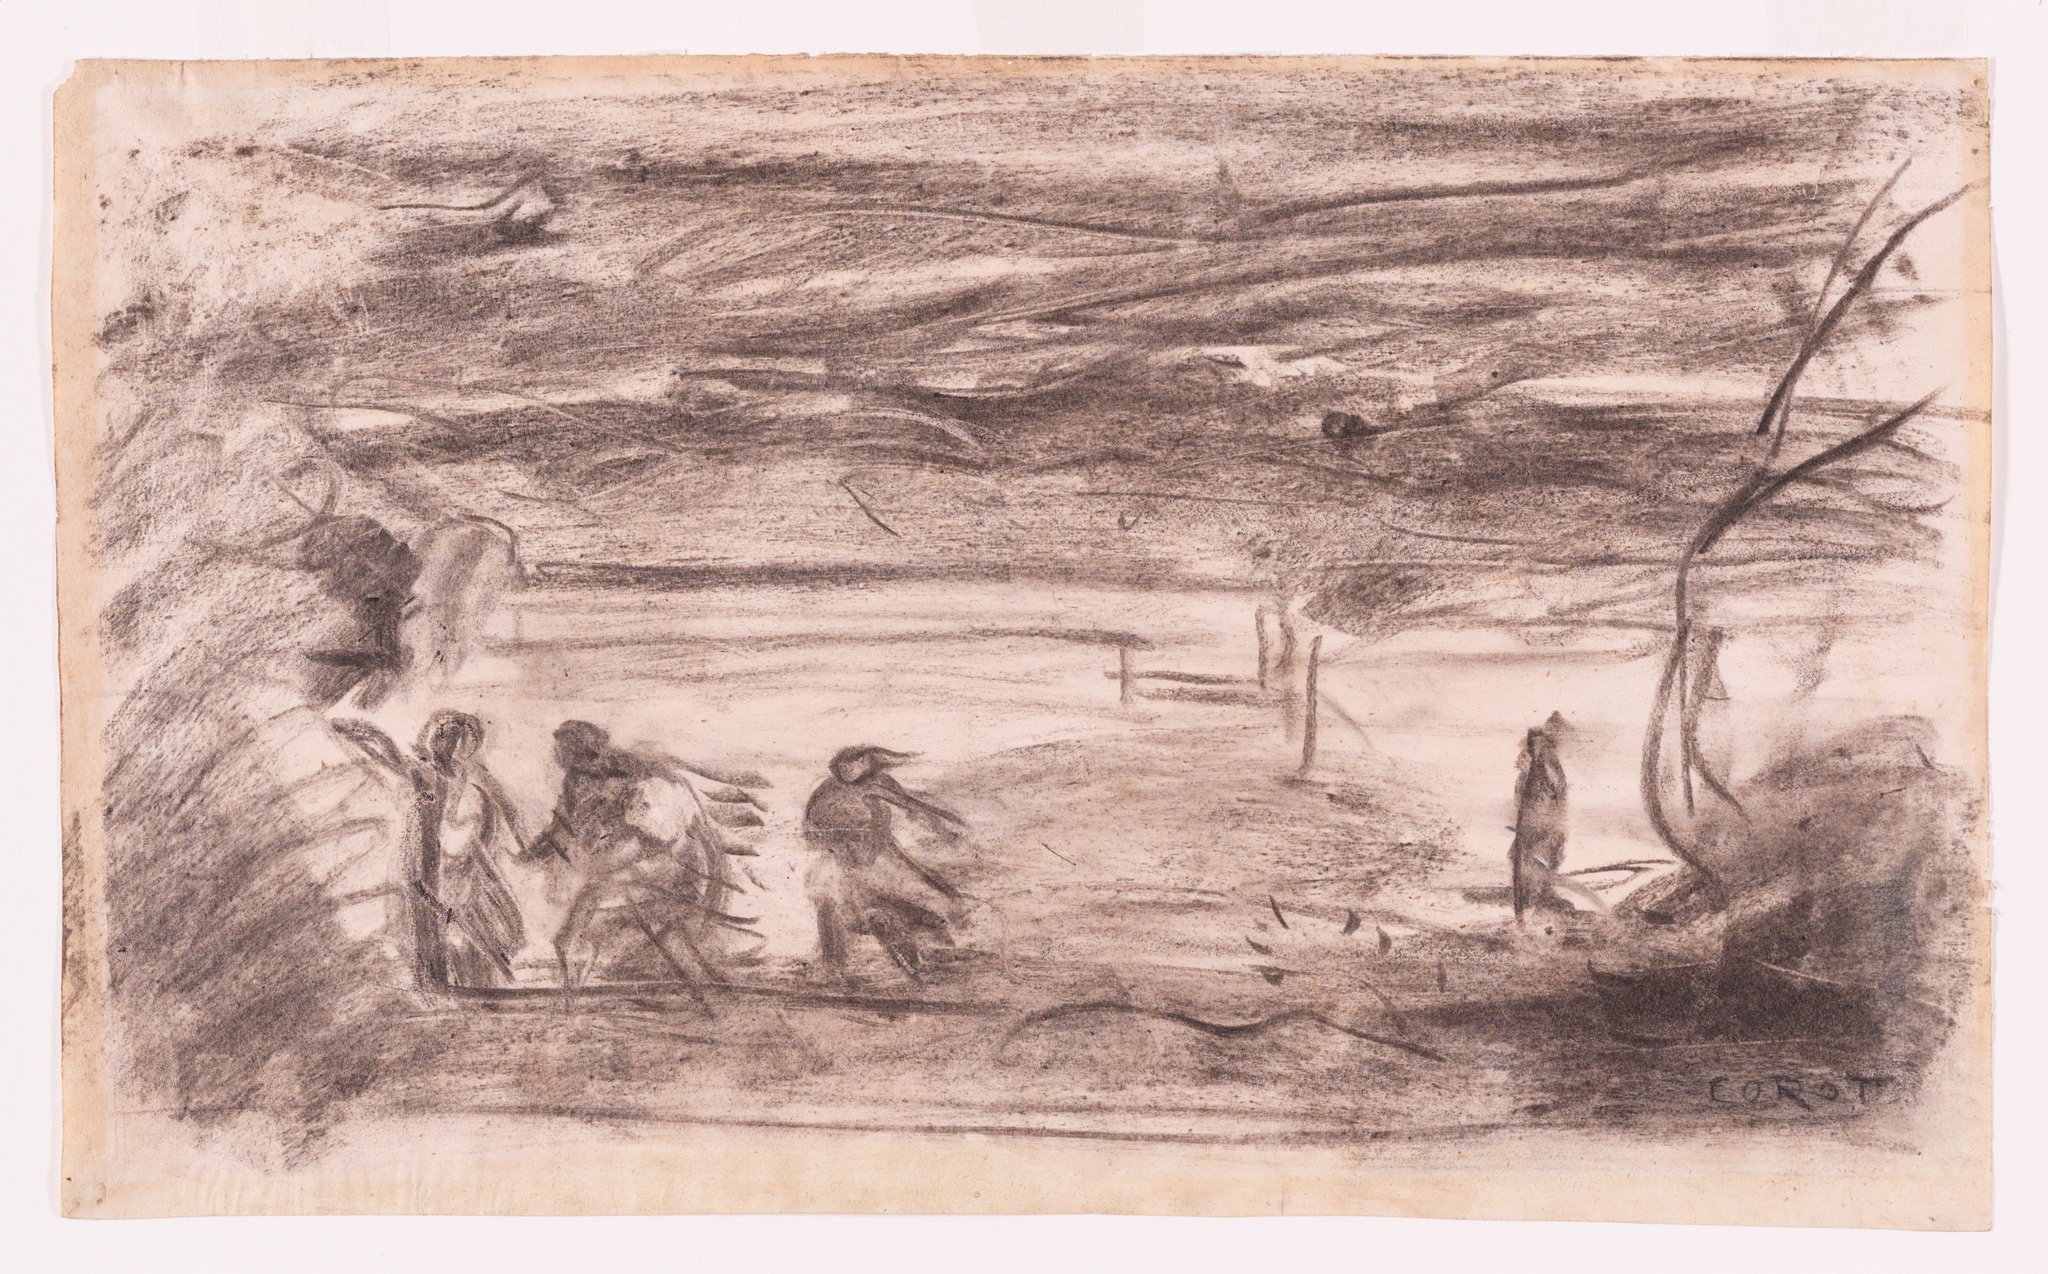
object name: drawing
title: The Destruction of Sodom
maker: jean-baptiste-camille corot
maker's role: artist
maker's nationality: french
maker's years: 1796-1875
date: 1857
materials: charcoal